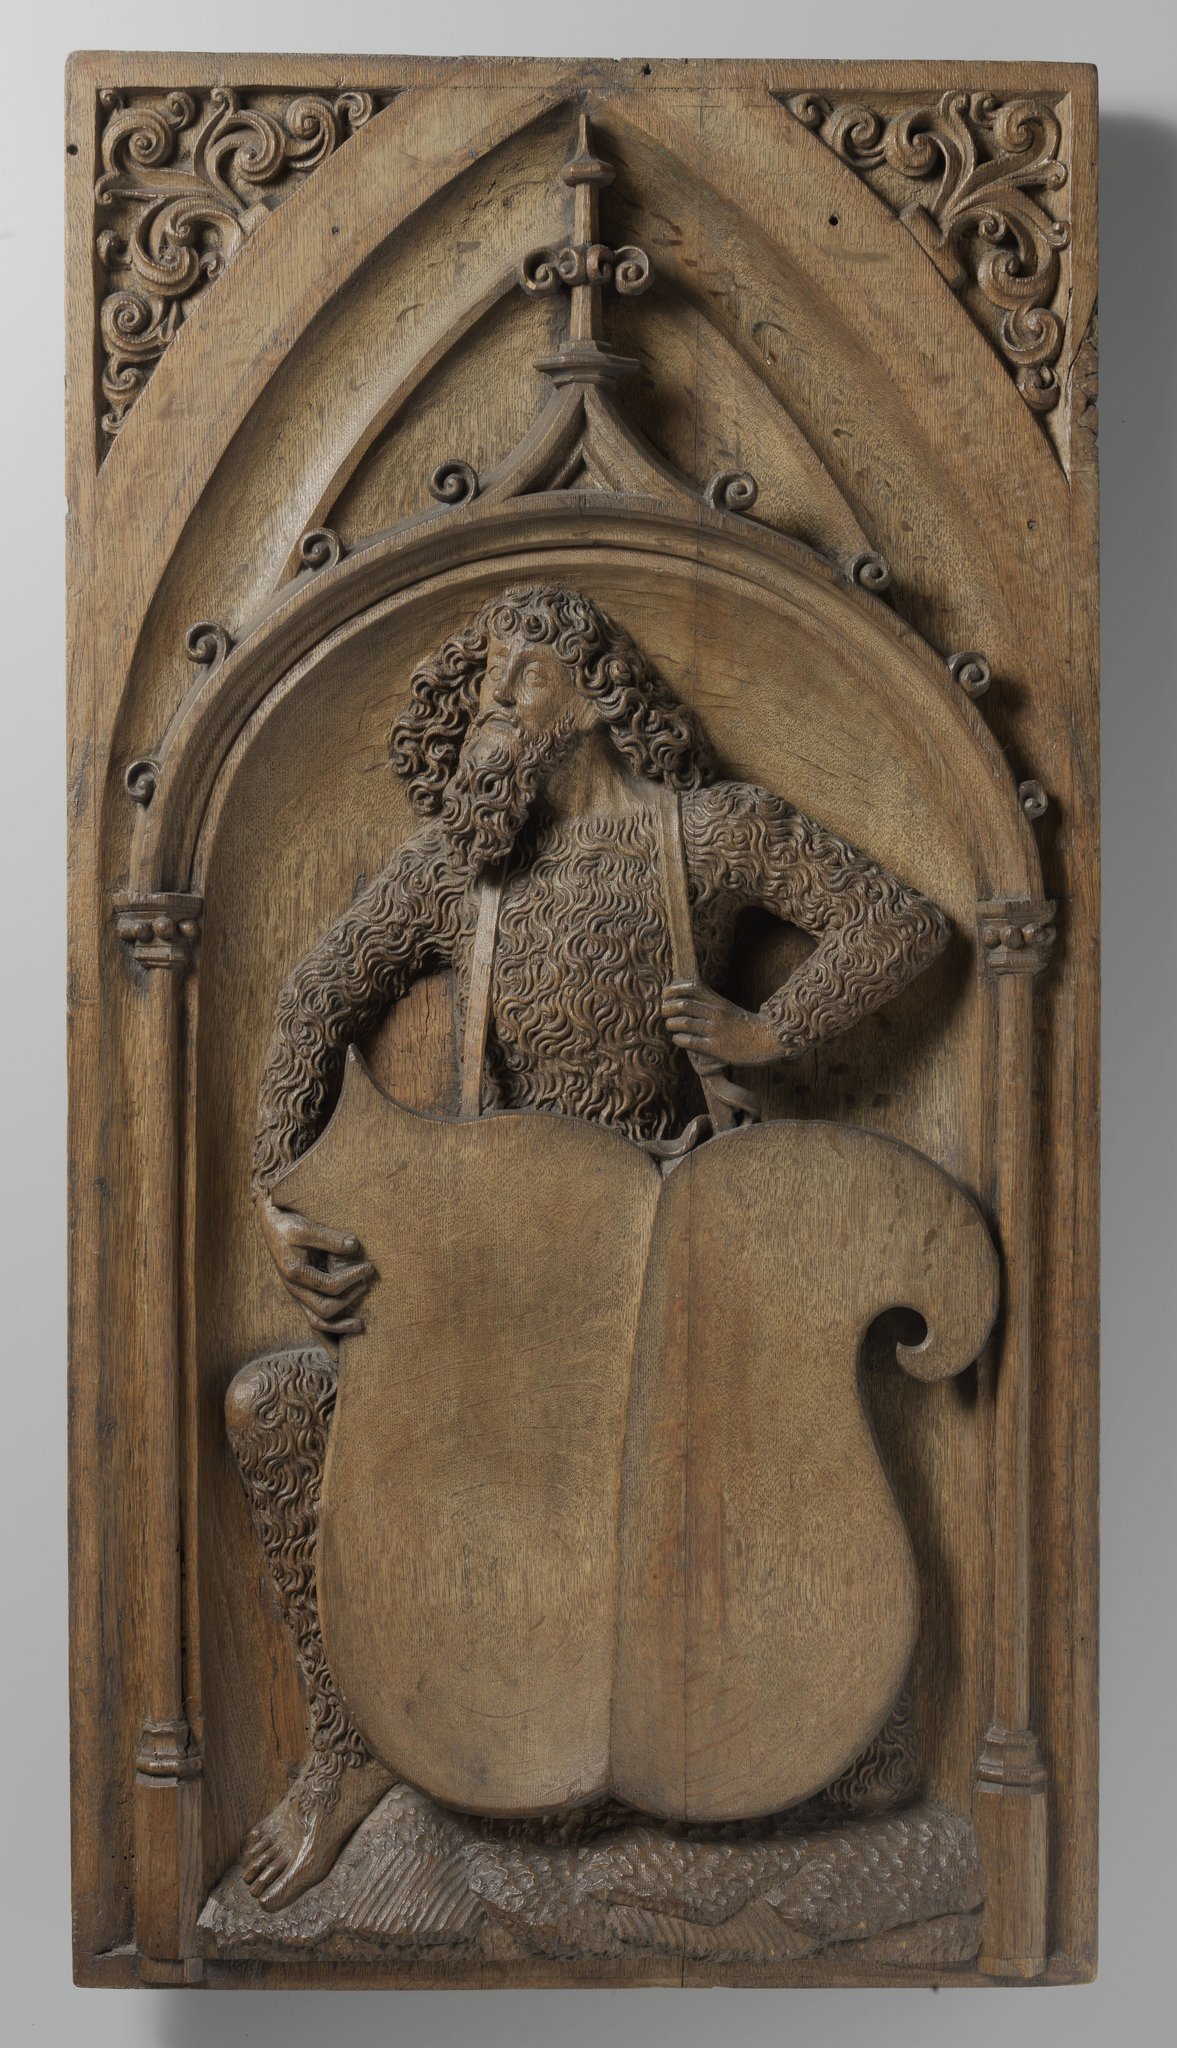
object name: orgelkast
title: Panel with a Wild Man Supporting an Escutcheon, from the Organ of the Sint-Vituskerk, Naarden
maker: jan eerstensz van schayck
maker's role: sculptor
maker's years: 1470-1527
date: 1510-1520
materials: wood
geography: utrecht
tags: wild man, wodewose, woodehouse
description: These ten figures adorned the medieval organ in the church of Saint Vitus in Naarden. Each figure holds a weapon and a coat of arms on a strap. Some are dressed as knights with a breastplate and a helmet, others as princes or noblemen. They may represent the Counts of Holland. All the shields would have originally been painted.